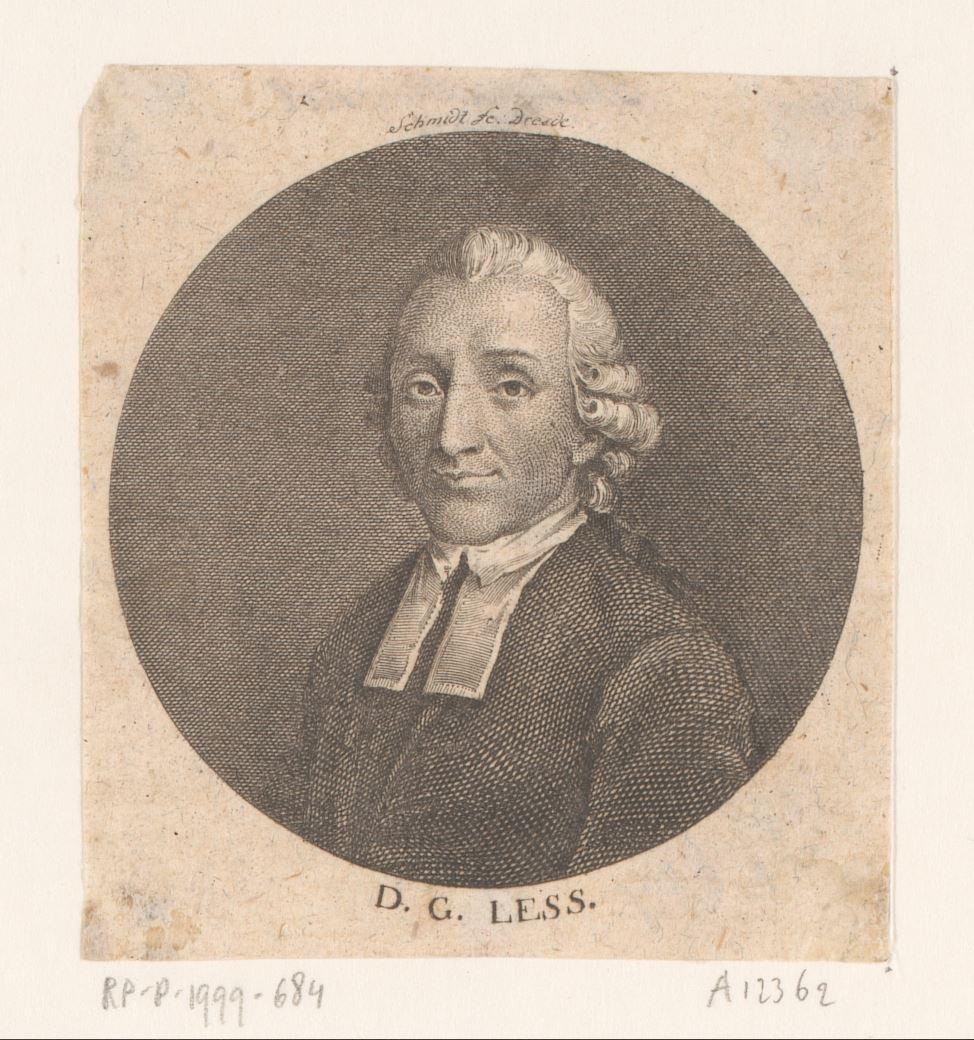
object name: print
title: Portret van Gottfried Less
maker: johann gottfried schmidt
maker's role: print maker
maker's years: 1764-1803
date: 1774-1803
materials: paper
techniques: engraving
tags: poland, historical persons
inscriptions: collector's mark: Lugt 2228, collector's mark